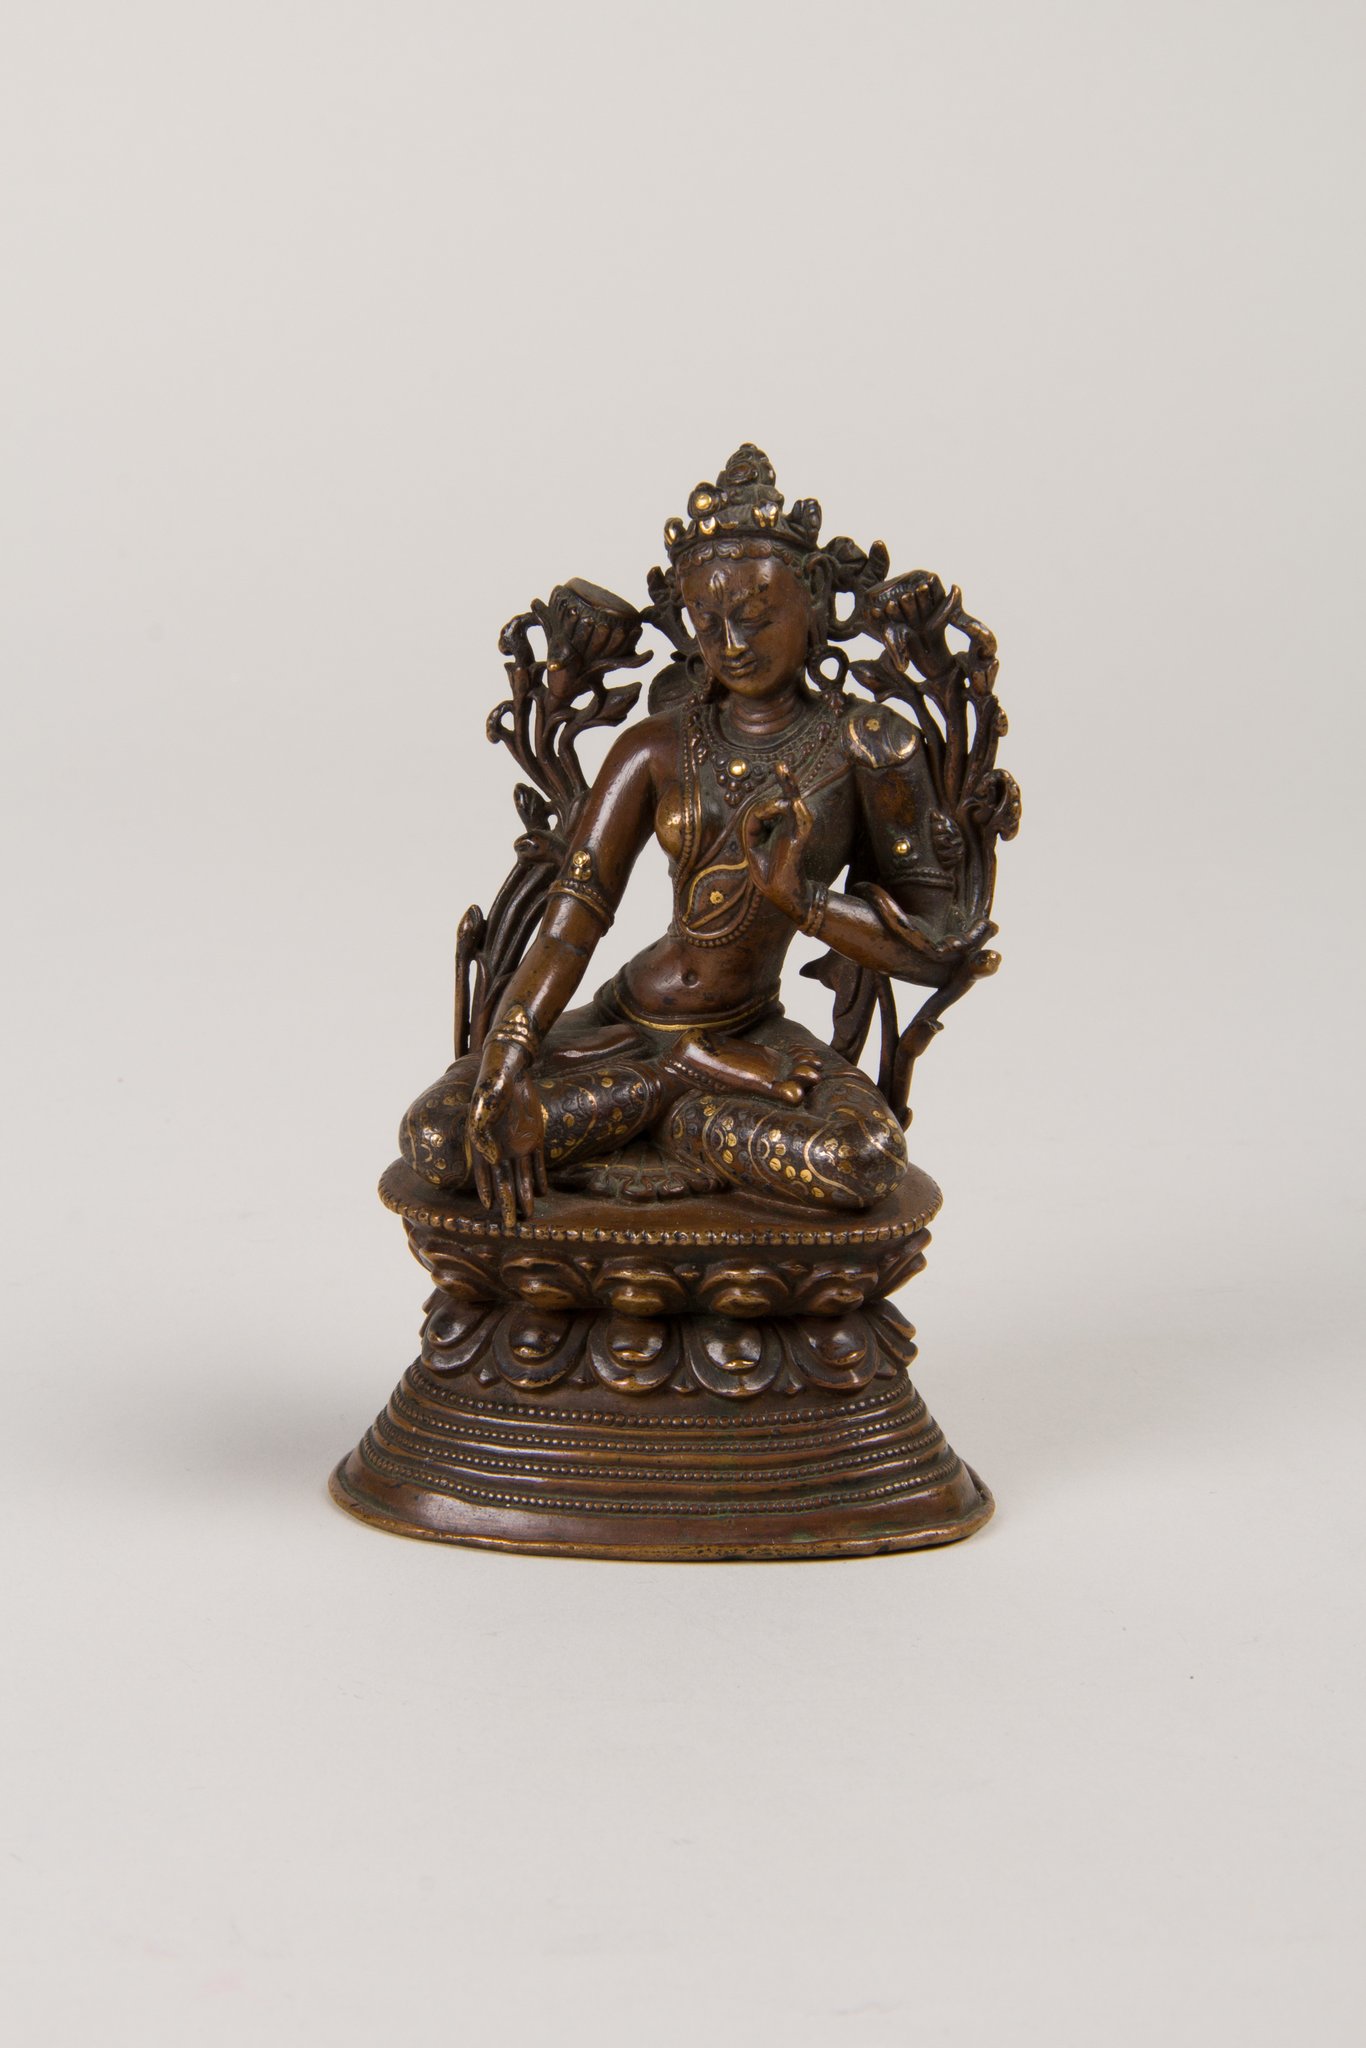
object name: figure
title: Seated Tara, the Buddhist Savior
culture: tibetan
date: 1201-1500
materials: copper alloy, gold, silver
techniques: inlay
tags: buddhism,deities